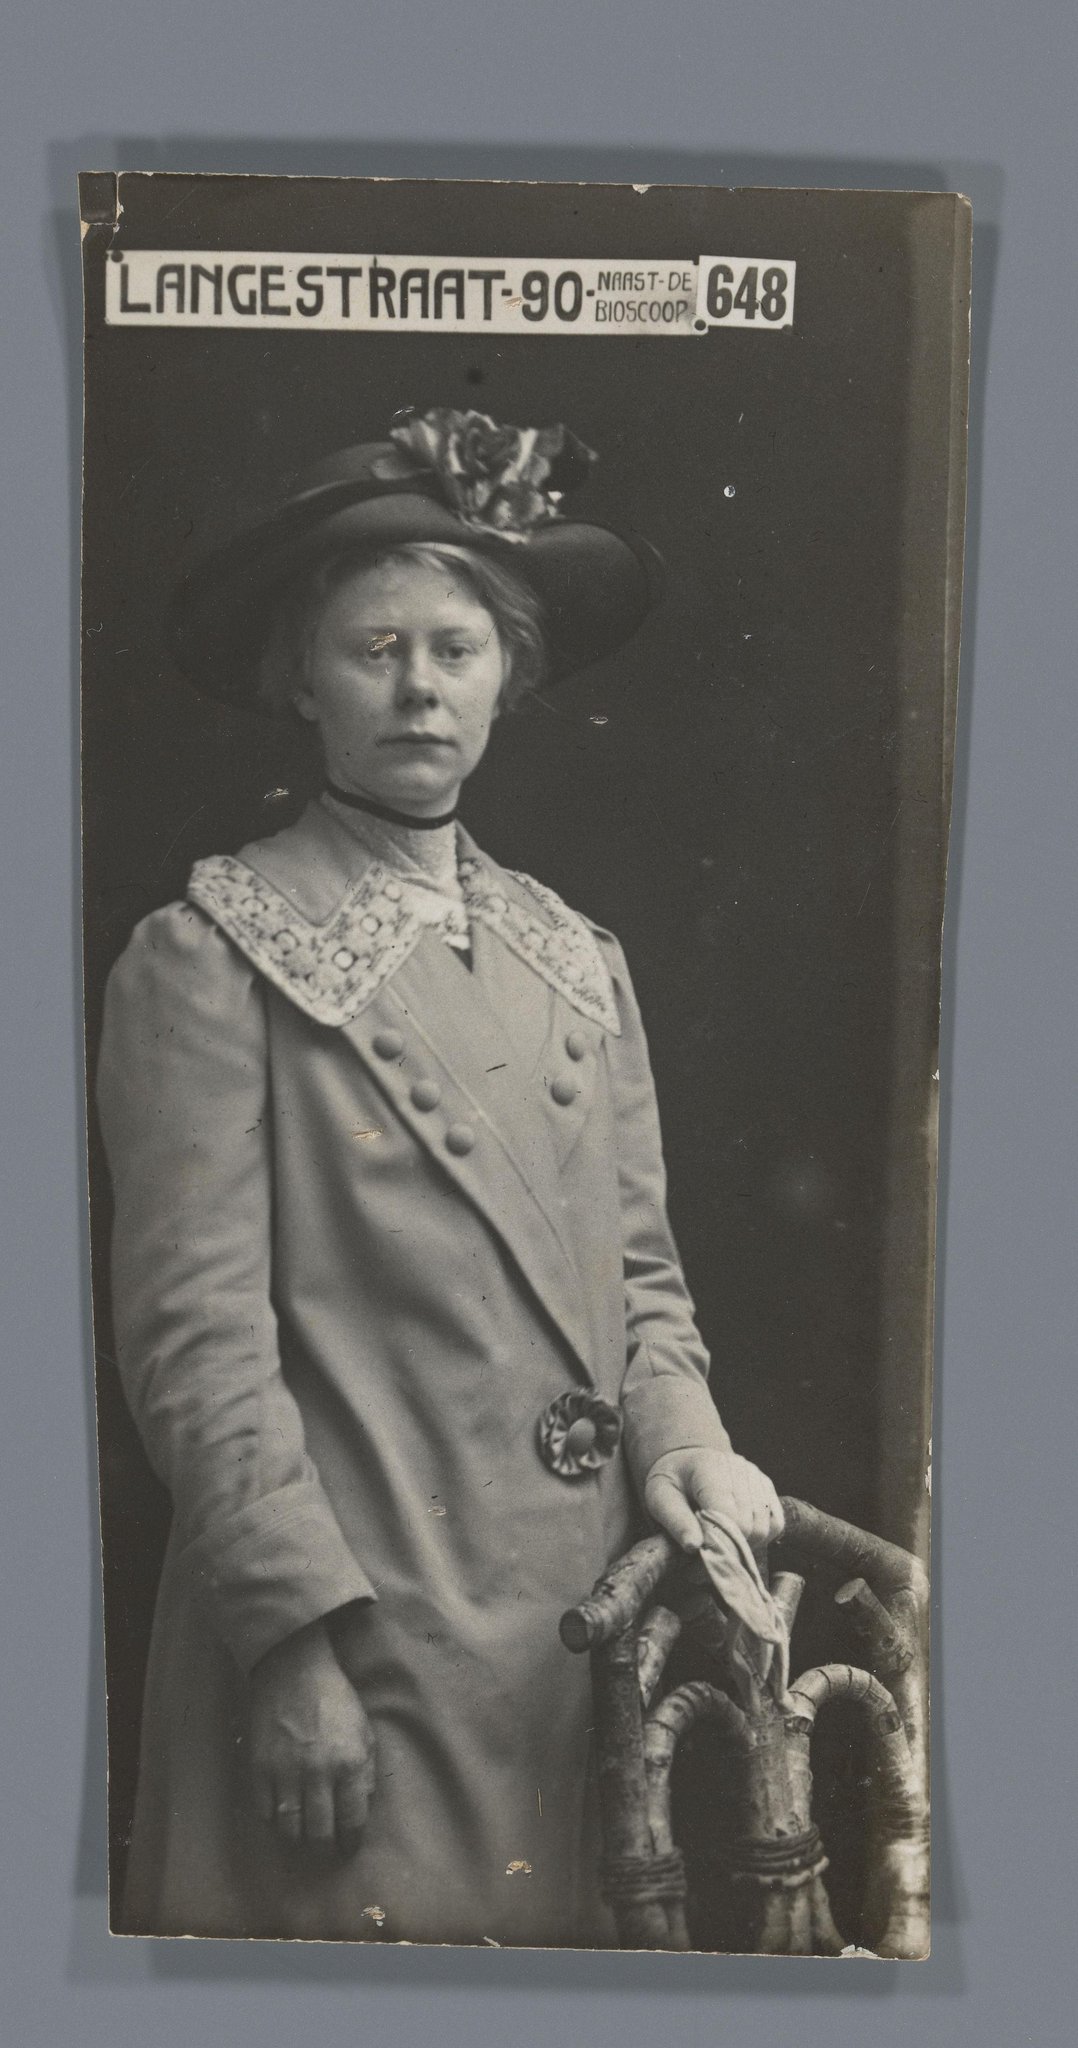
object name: snapshot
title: Rapid photographs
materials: photographic support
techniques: gelatin silver print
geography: alkmaar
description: Between 1912 and 1930, anyone could have their portrait taken at the many so-called rapid photography studios in the shopping streets of mainly (medium) large-size European cities. As if on an assembly line, the youngest clerk shot the photographs with a special camera and in artificial light and developed them. Later in the day, the customer collected a sheet with 12 portrait photos for 25 cents. This form of photographic mass production gave rise to a fascinating tableau of boys, girls, men and women not previously seen in photographs; candid and informal. There were at least 150 quick-photo studios, from Alkmaar to Zutphen. Many called themselves ‘American,’ mistakenly as it turns out because hardly any examples from that country have been found.